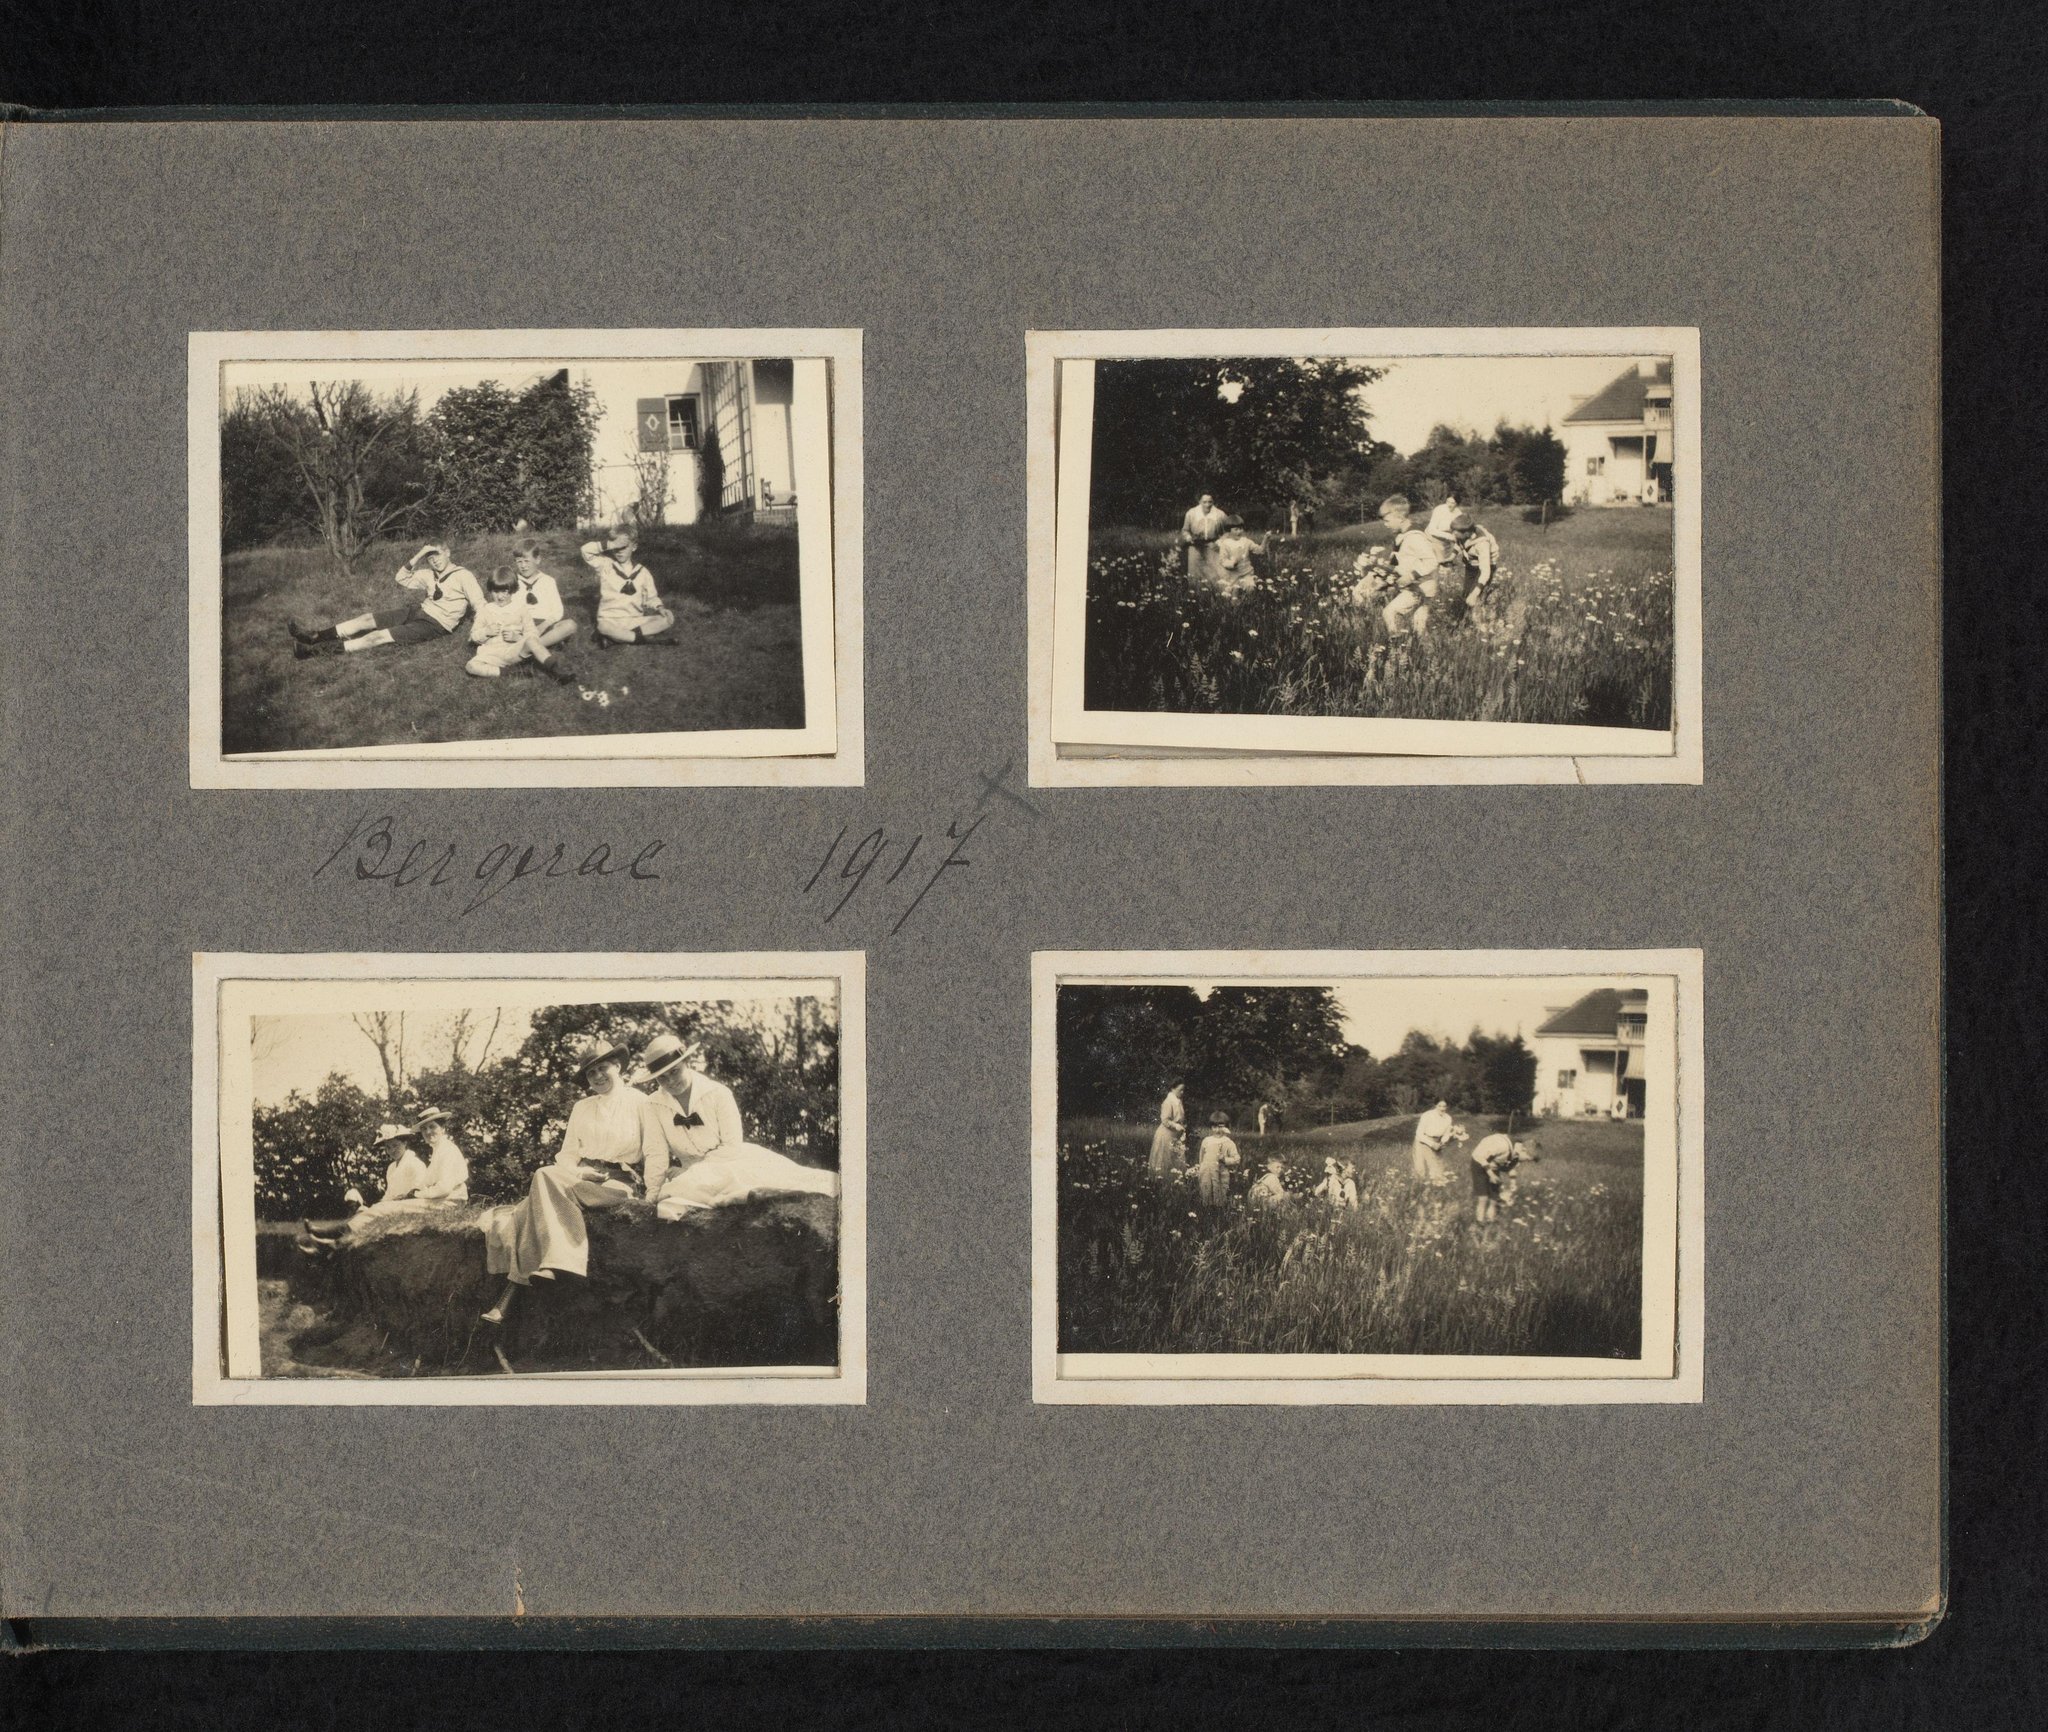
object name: album leaf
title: Kinderen van de familie van den Berg in een tuin in Bergerac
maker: hendrik herman van den berg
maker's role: amateurfotograaf, jurist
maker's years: 1875-1944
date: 1917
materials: paper, cardboard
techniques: gelatin silver print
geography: bergerac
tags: family life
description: Deze foto's zijn onderdeel van een album.